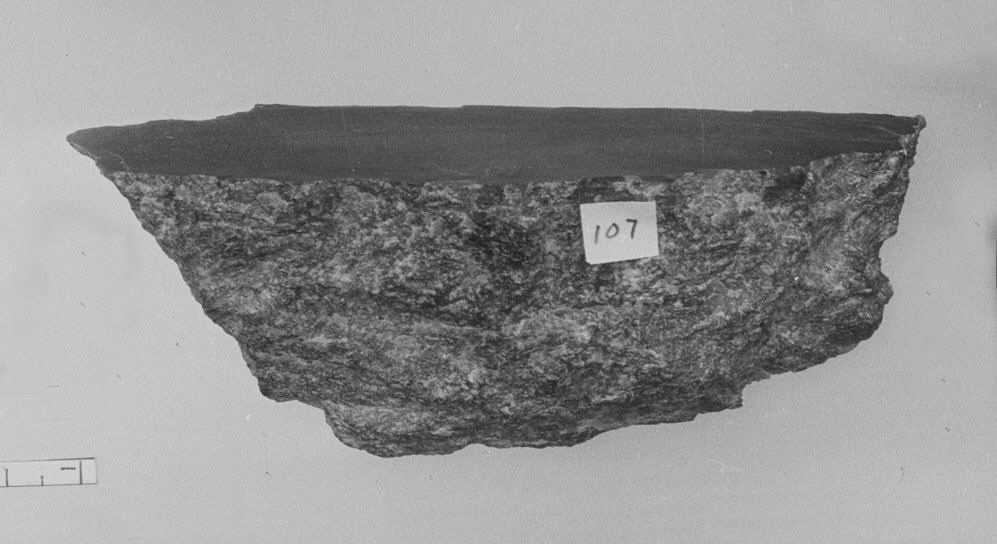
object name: fragment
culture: russian, siberia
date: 1902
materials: jade